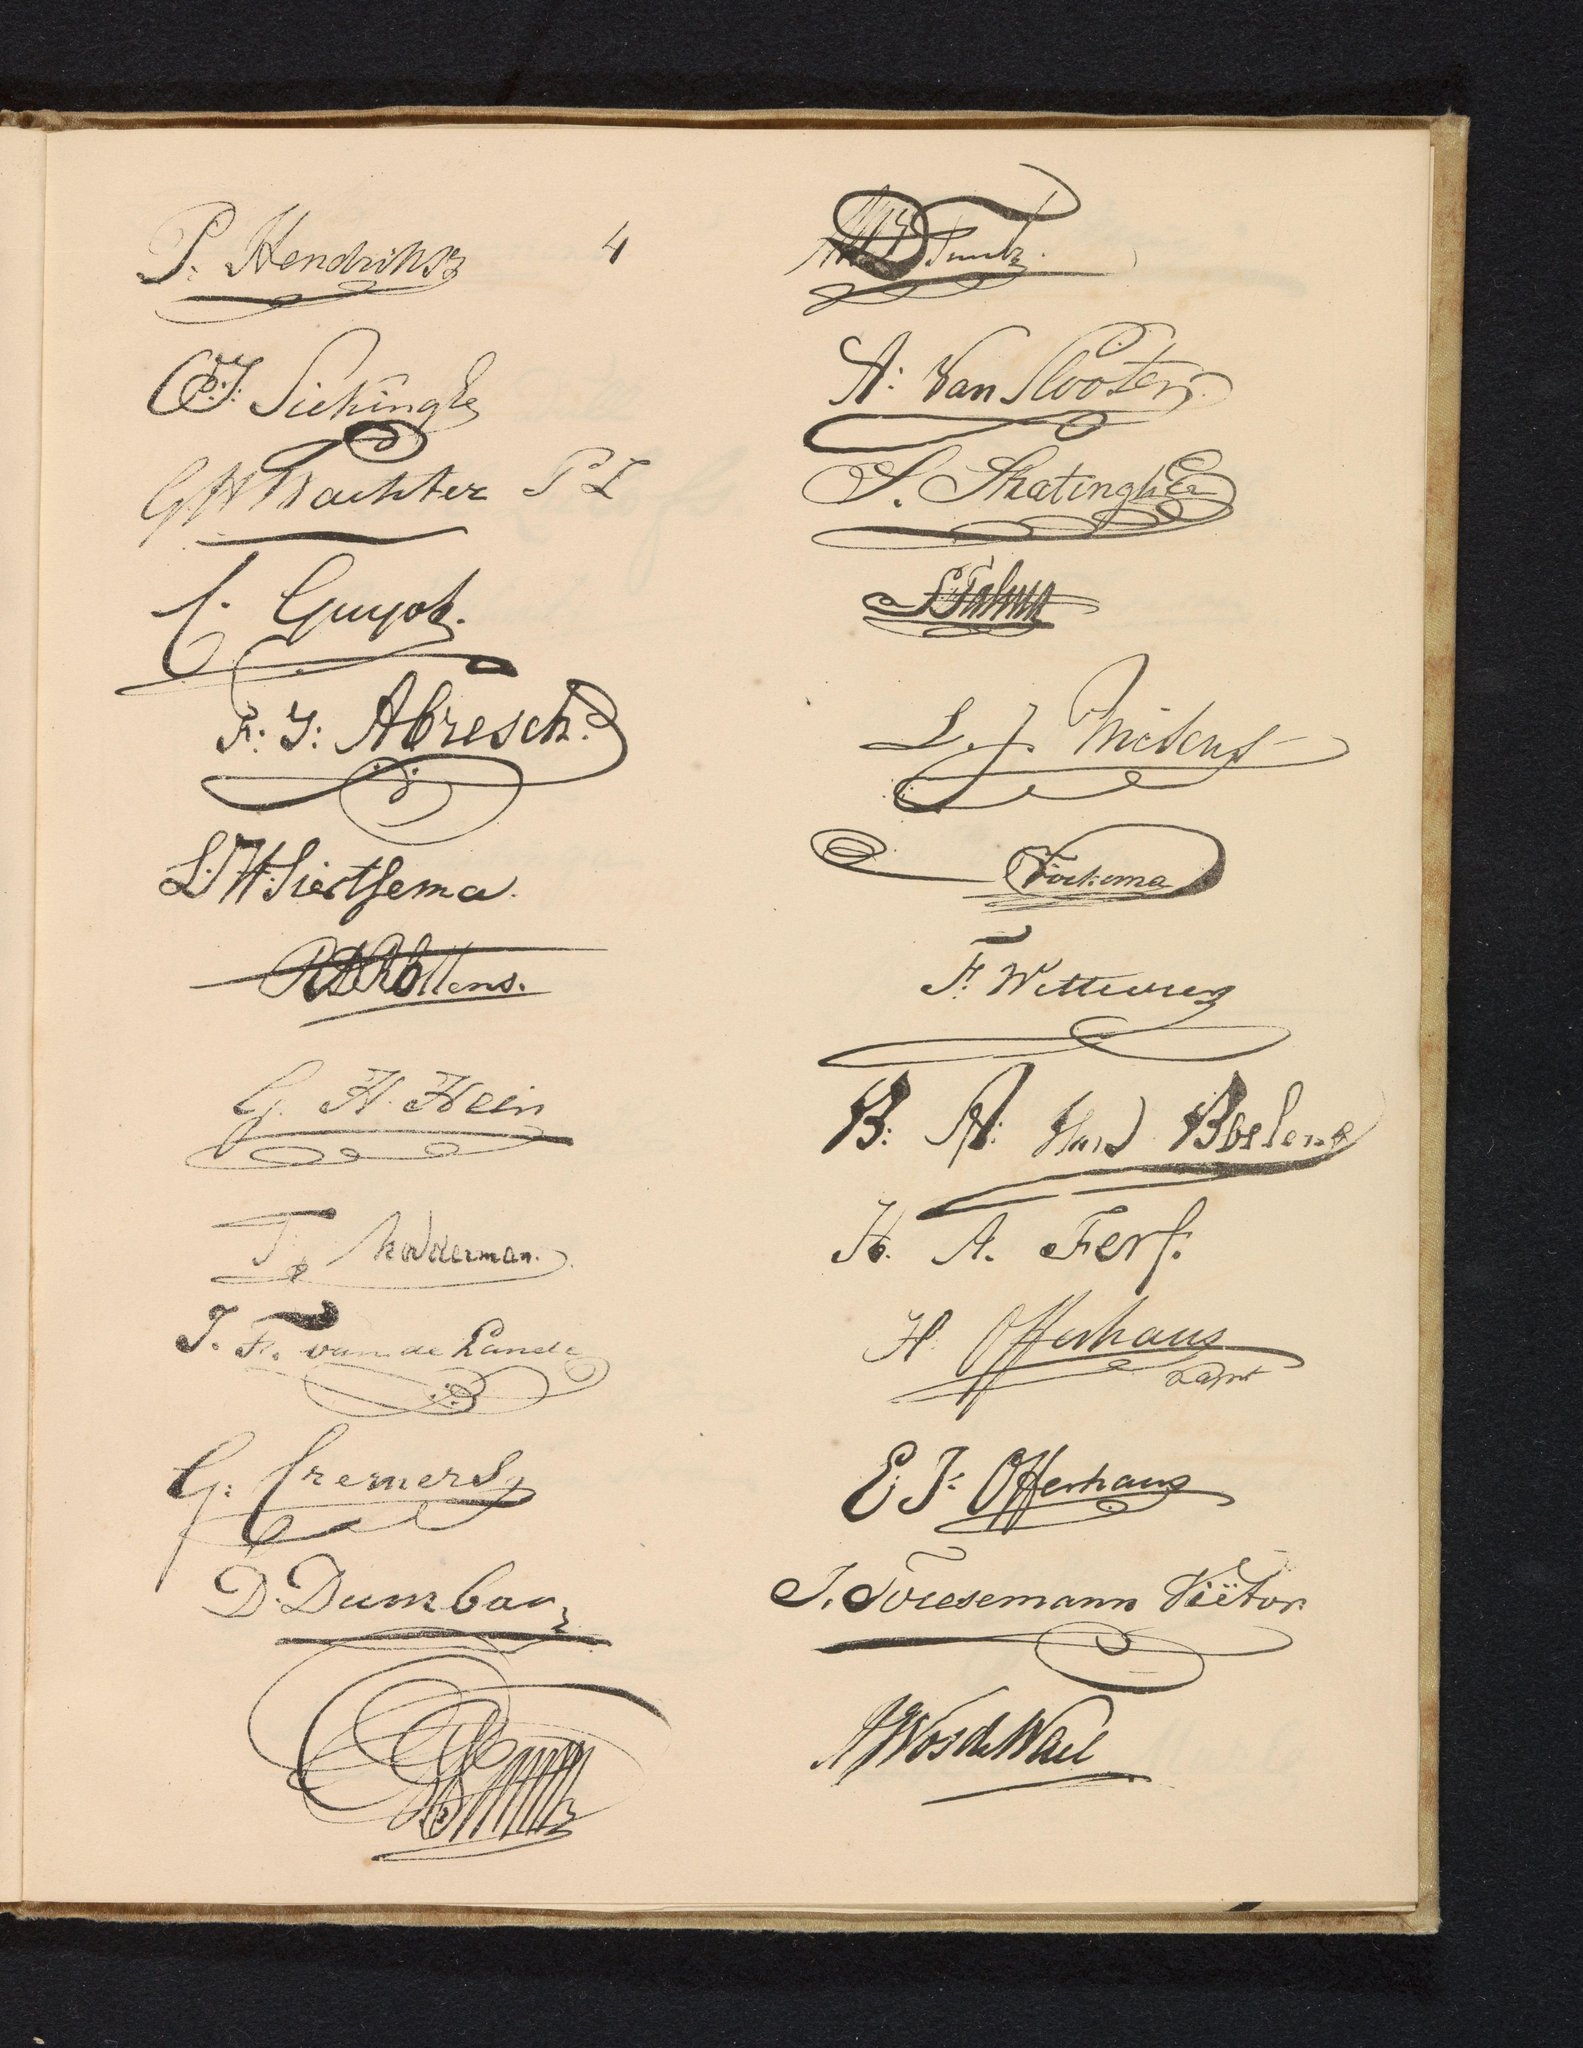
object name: print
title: Vierde blad met handtekeningen, 1830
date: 1807-1830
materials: paper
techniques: lithograph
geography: groningen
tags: title-page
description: Vierde blad met handtekeningen van de studenten in twee kolommen. Onderdeel van een boekje met de handtekeningen van de aanwezigen op het feest ter herdenking van de academische leeftijd op de Universiteit van Groningen op 1 juli 1830.